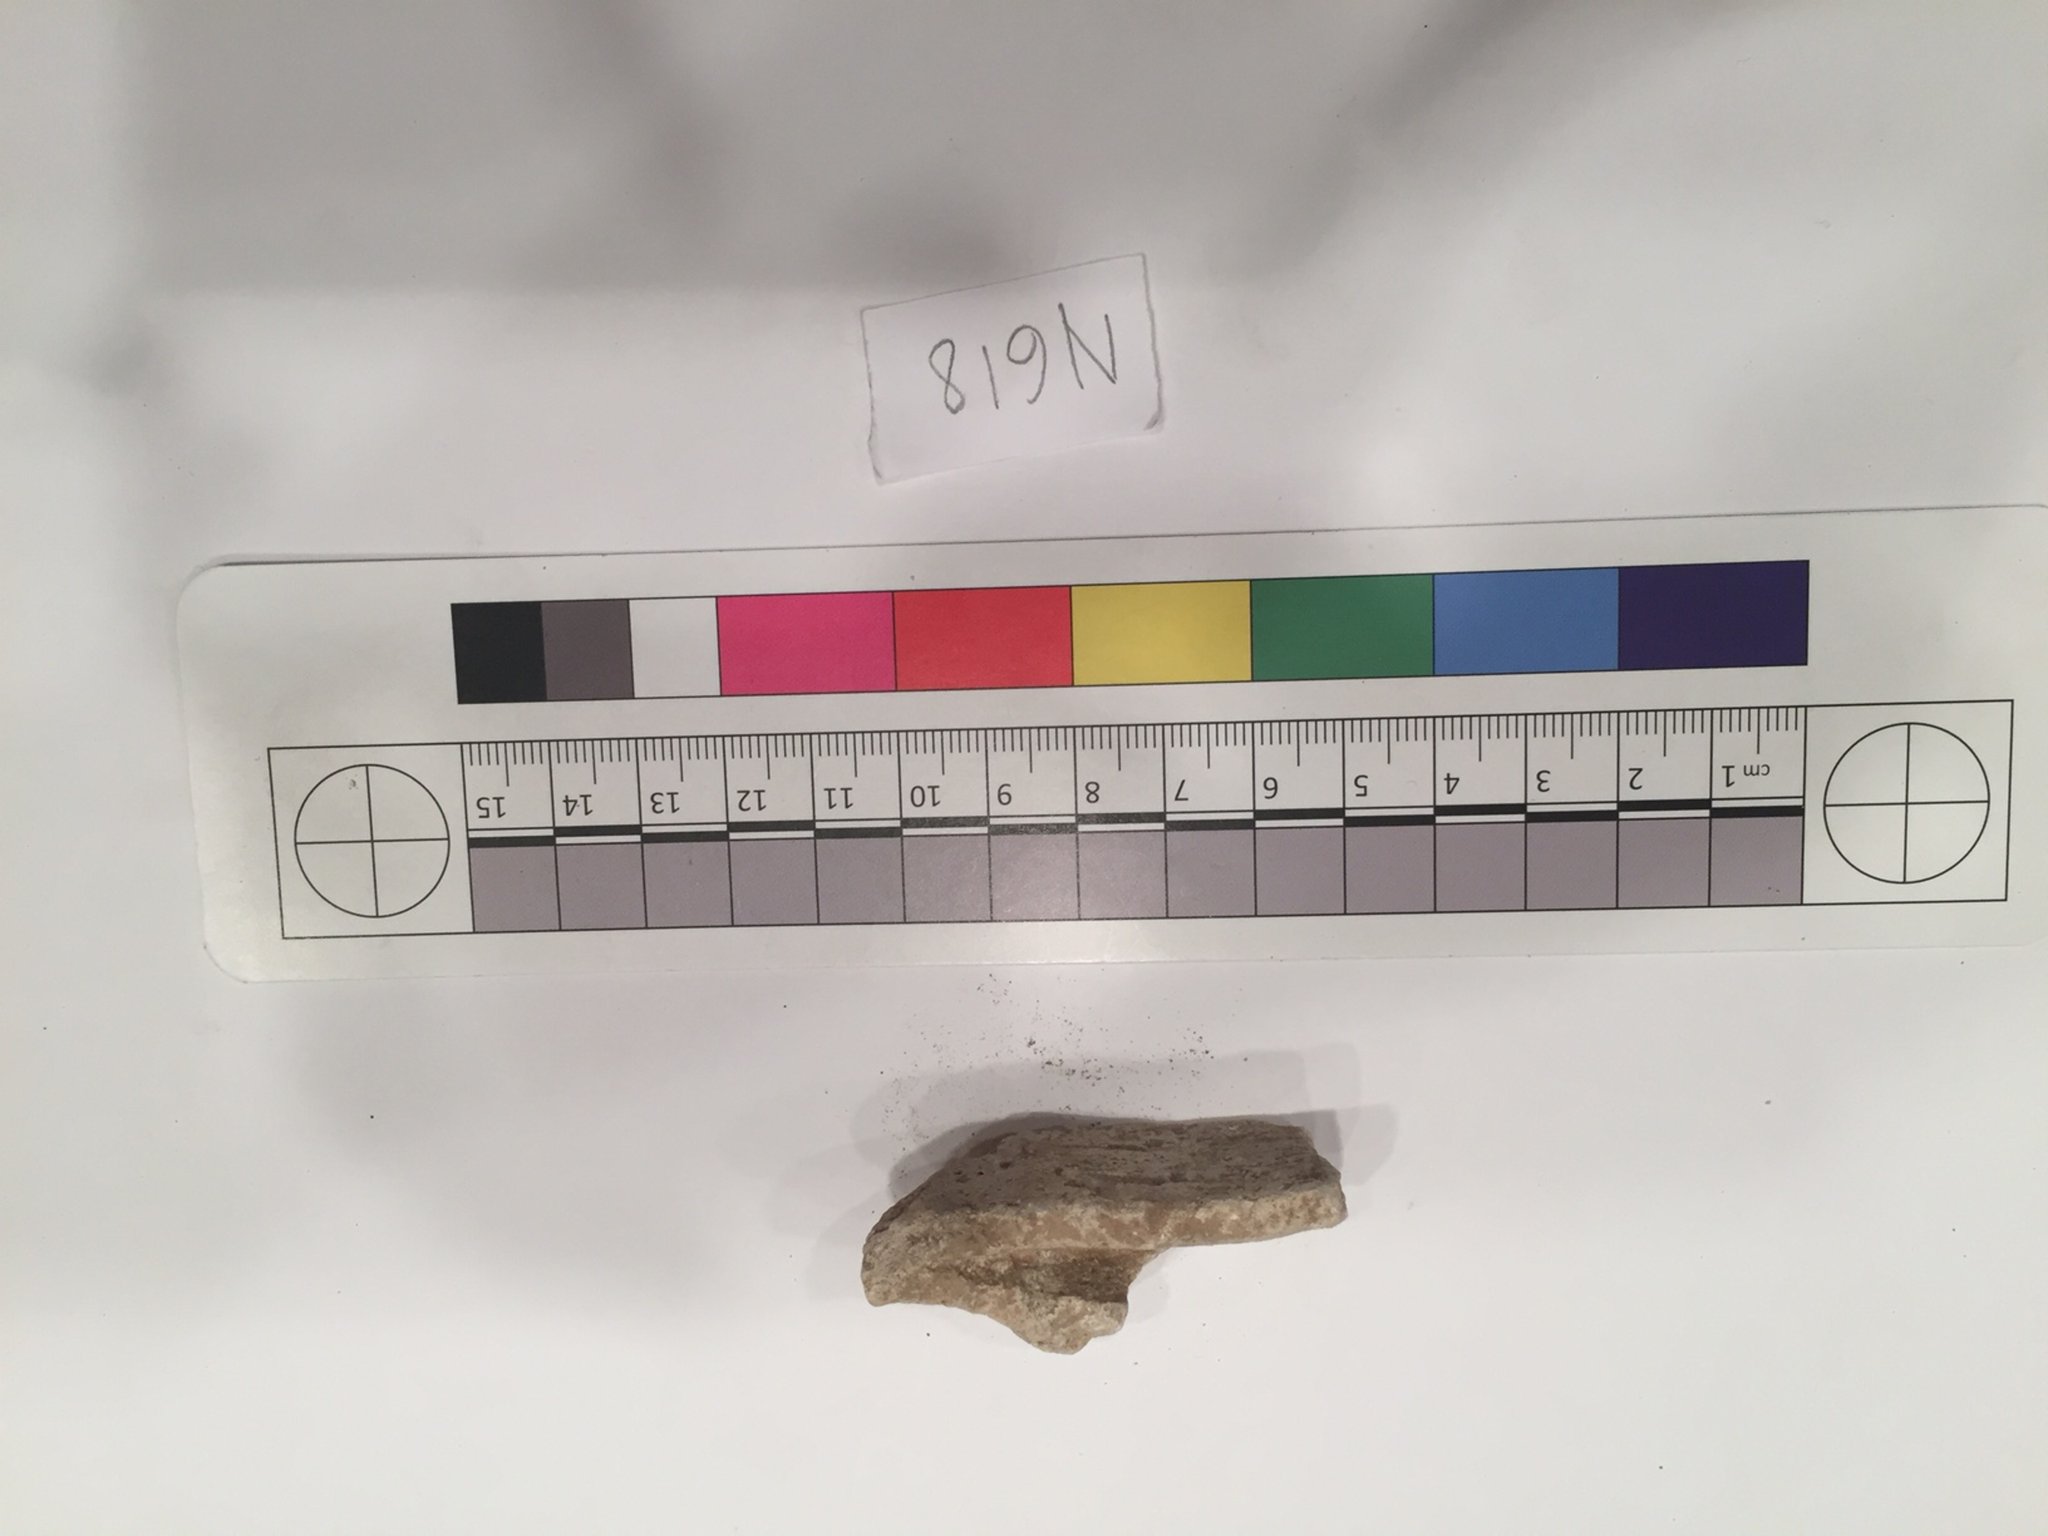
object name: fragment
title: Stucco Fragment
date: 701-1200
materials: plaster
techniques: carving, painting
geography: iran